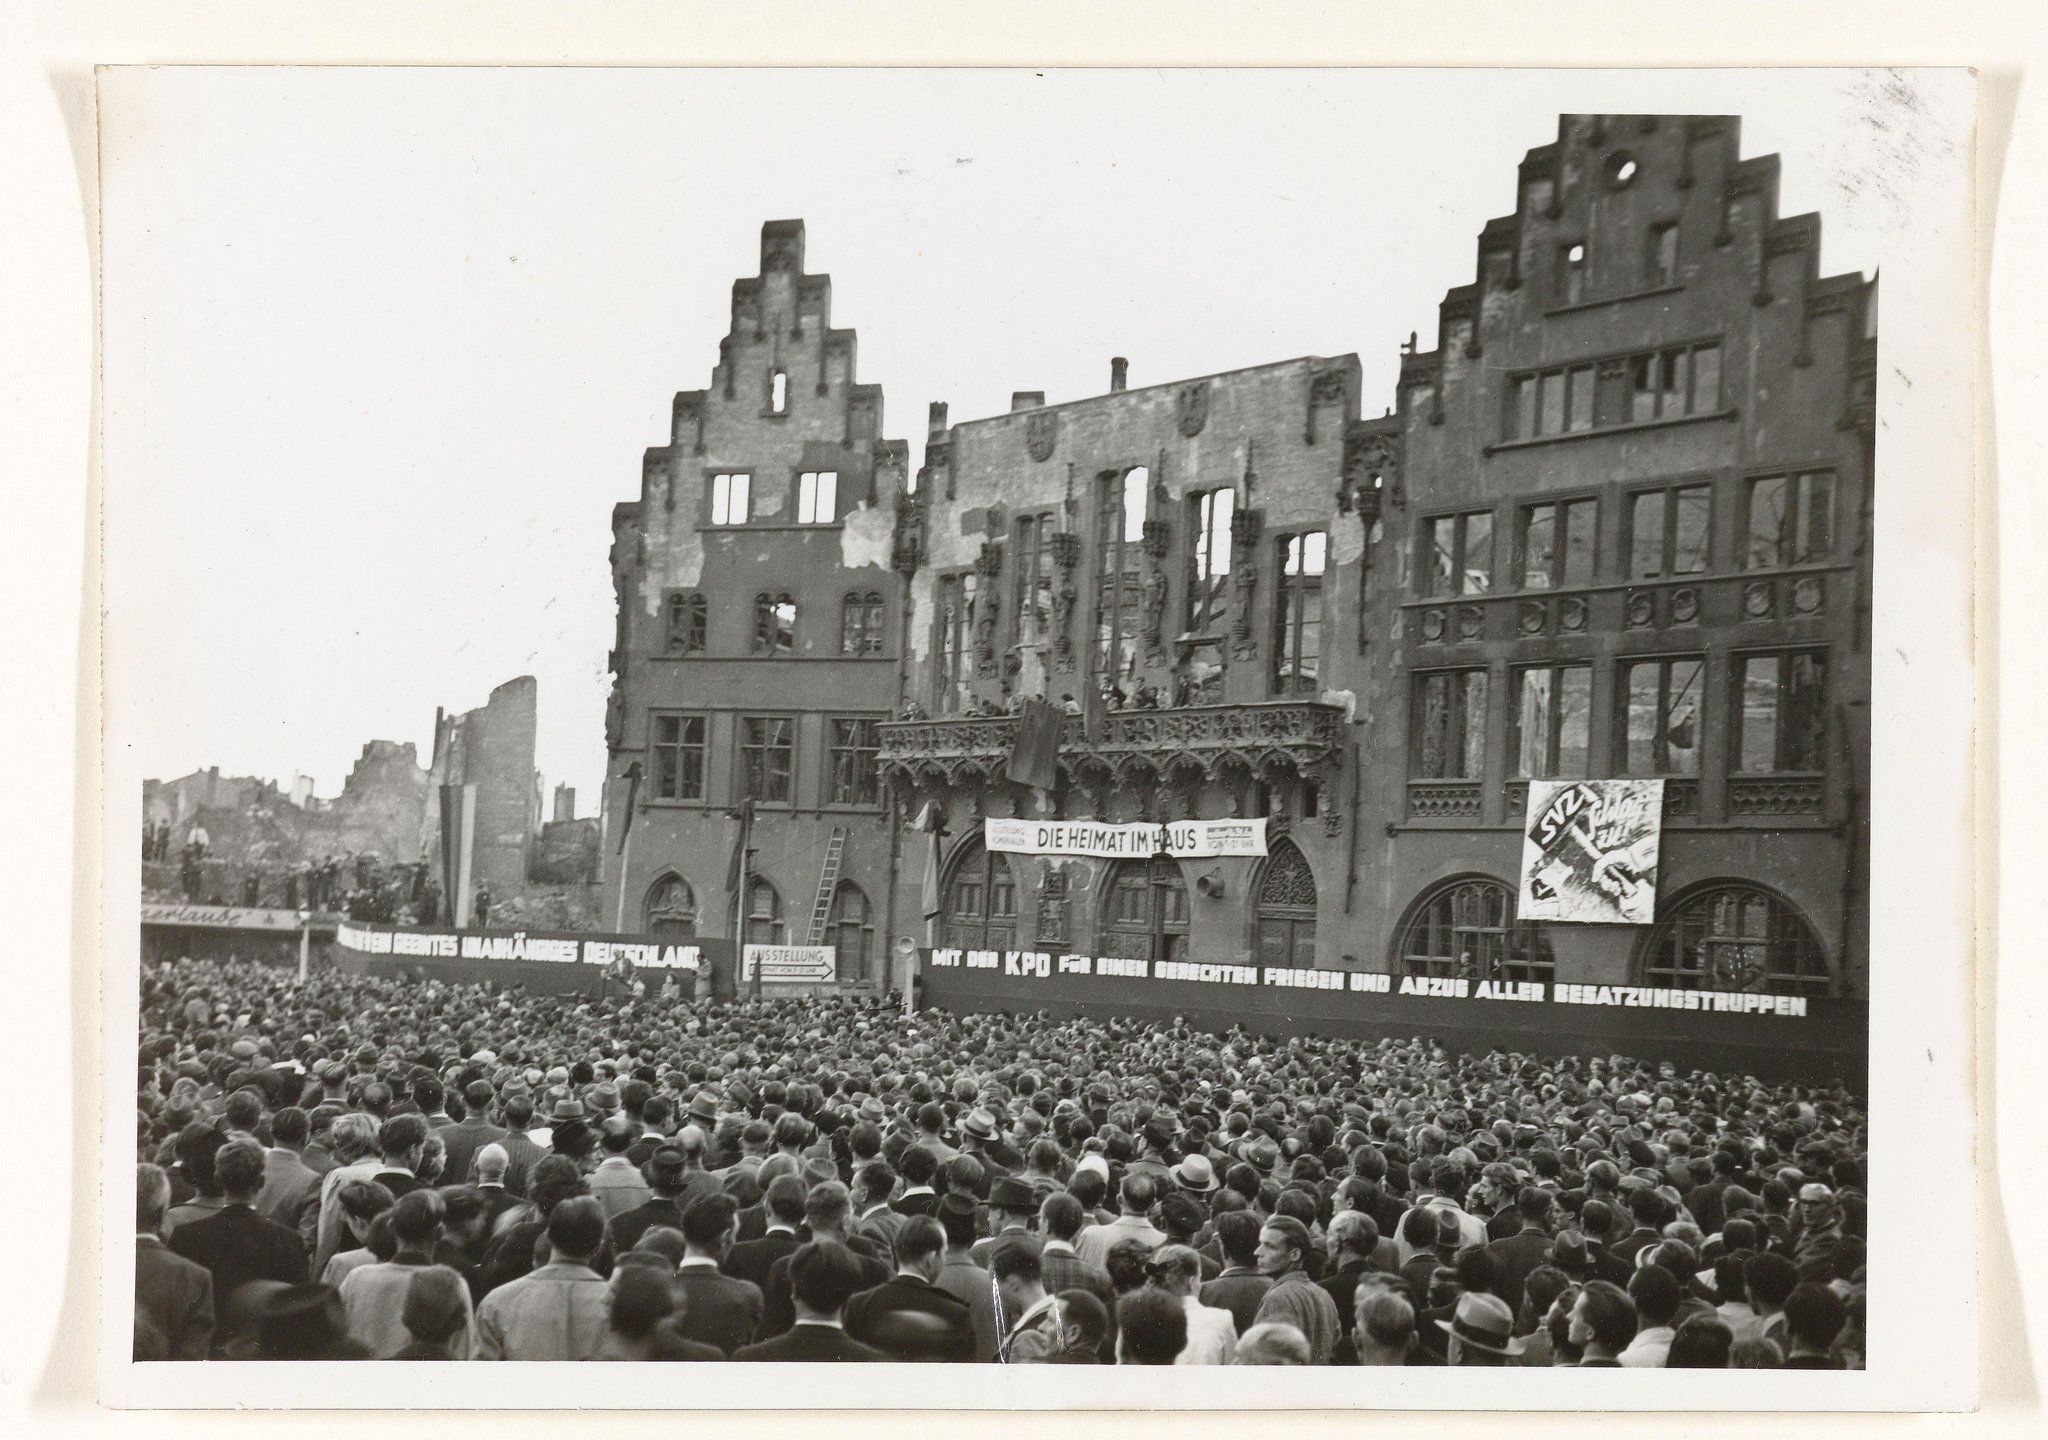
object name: photograph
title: Mensen menigte voor de Frankfurter Roemerberg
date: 1949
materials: photographic support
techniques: gelatin silver print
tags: frankfurt am main